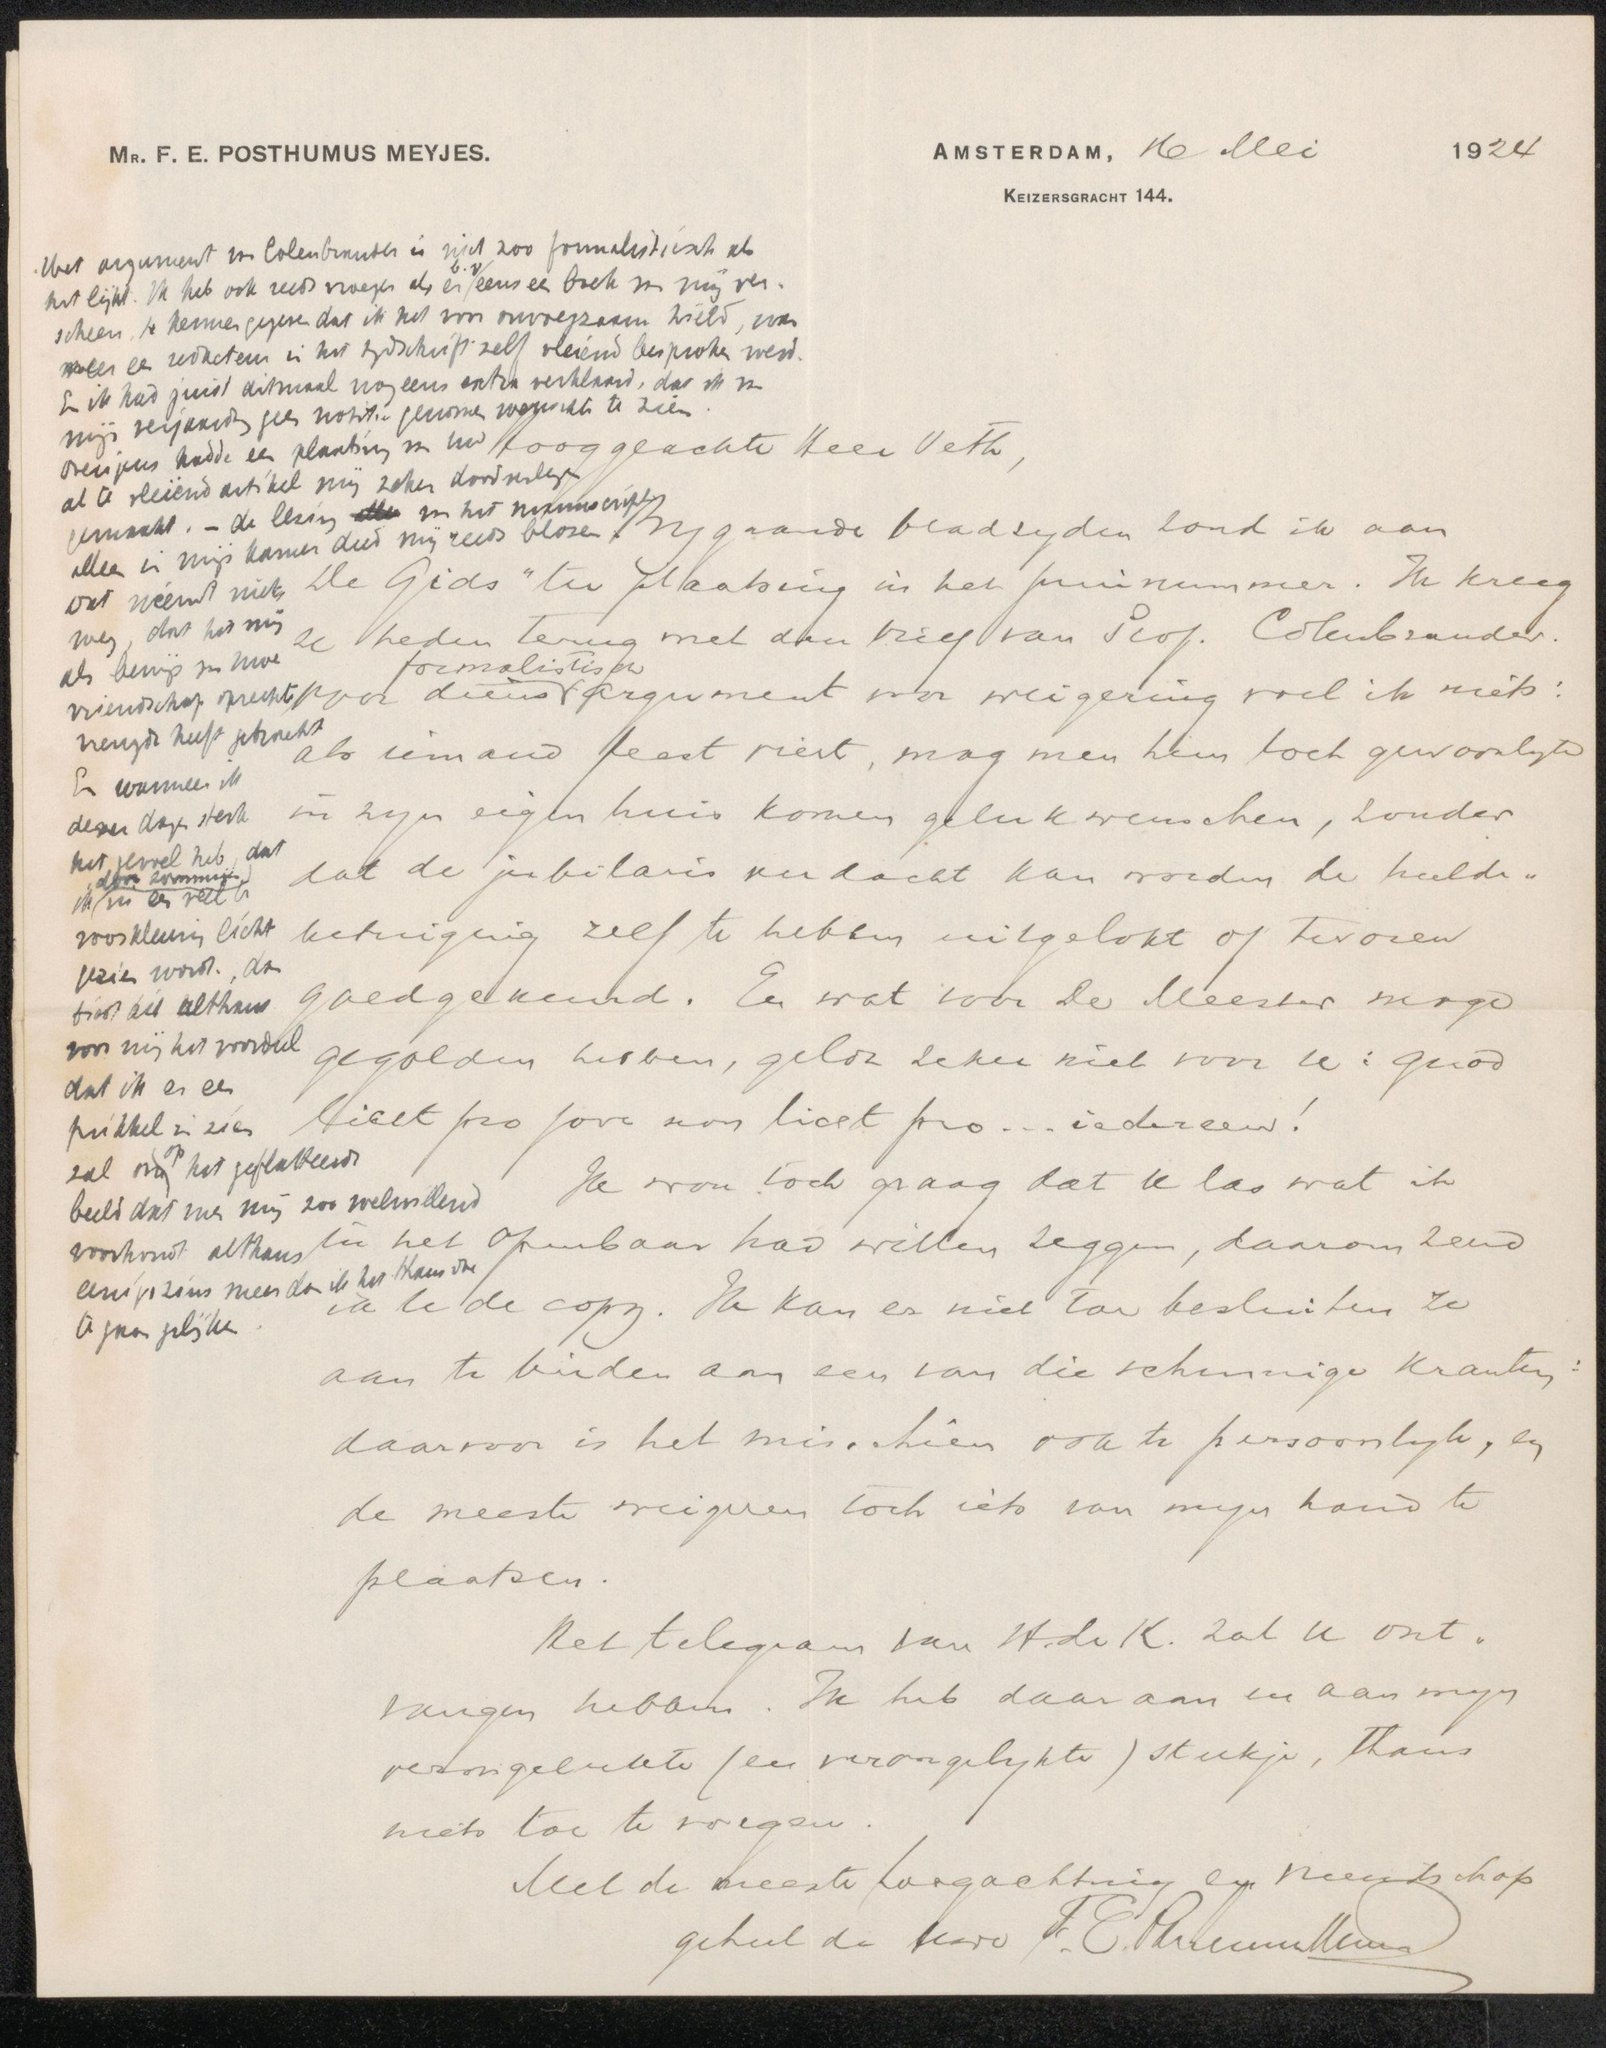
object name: letter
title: Brief aan Jan Veth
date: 1924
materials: ink, paper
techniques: pen, printing, writing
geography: amsterdam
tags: dordrecht, painter, print maker, draughtsman, designer, jan veth, leiden, herman theodoor colenbrander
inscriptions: watermark, collector's mark: ‘RPK’, name: ‘Mr. F.E. POSTHUMUS MEYJES.’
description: Brief bevat een aantekening van Jan Veth.